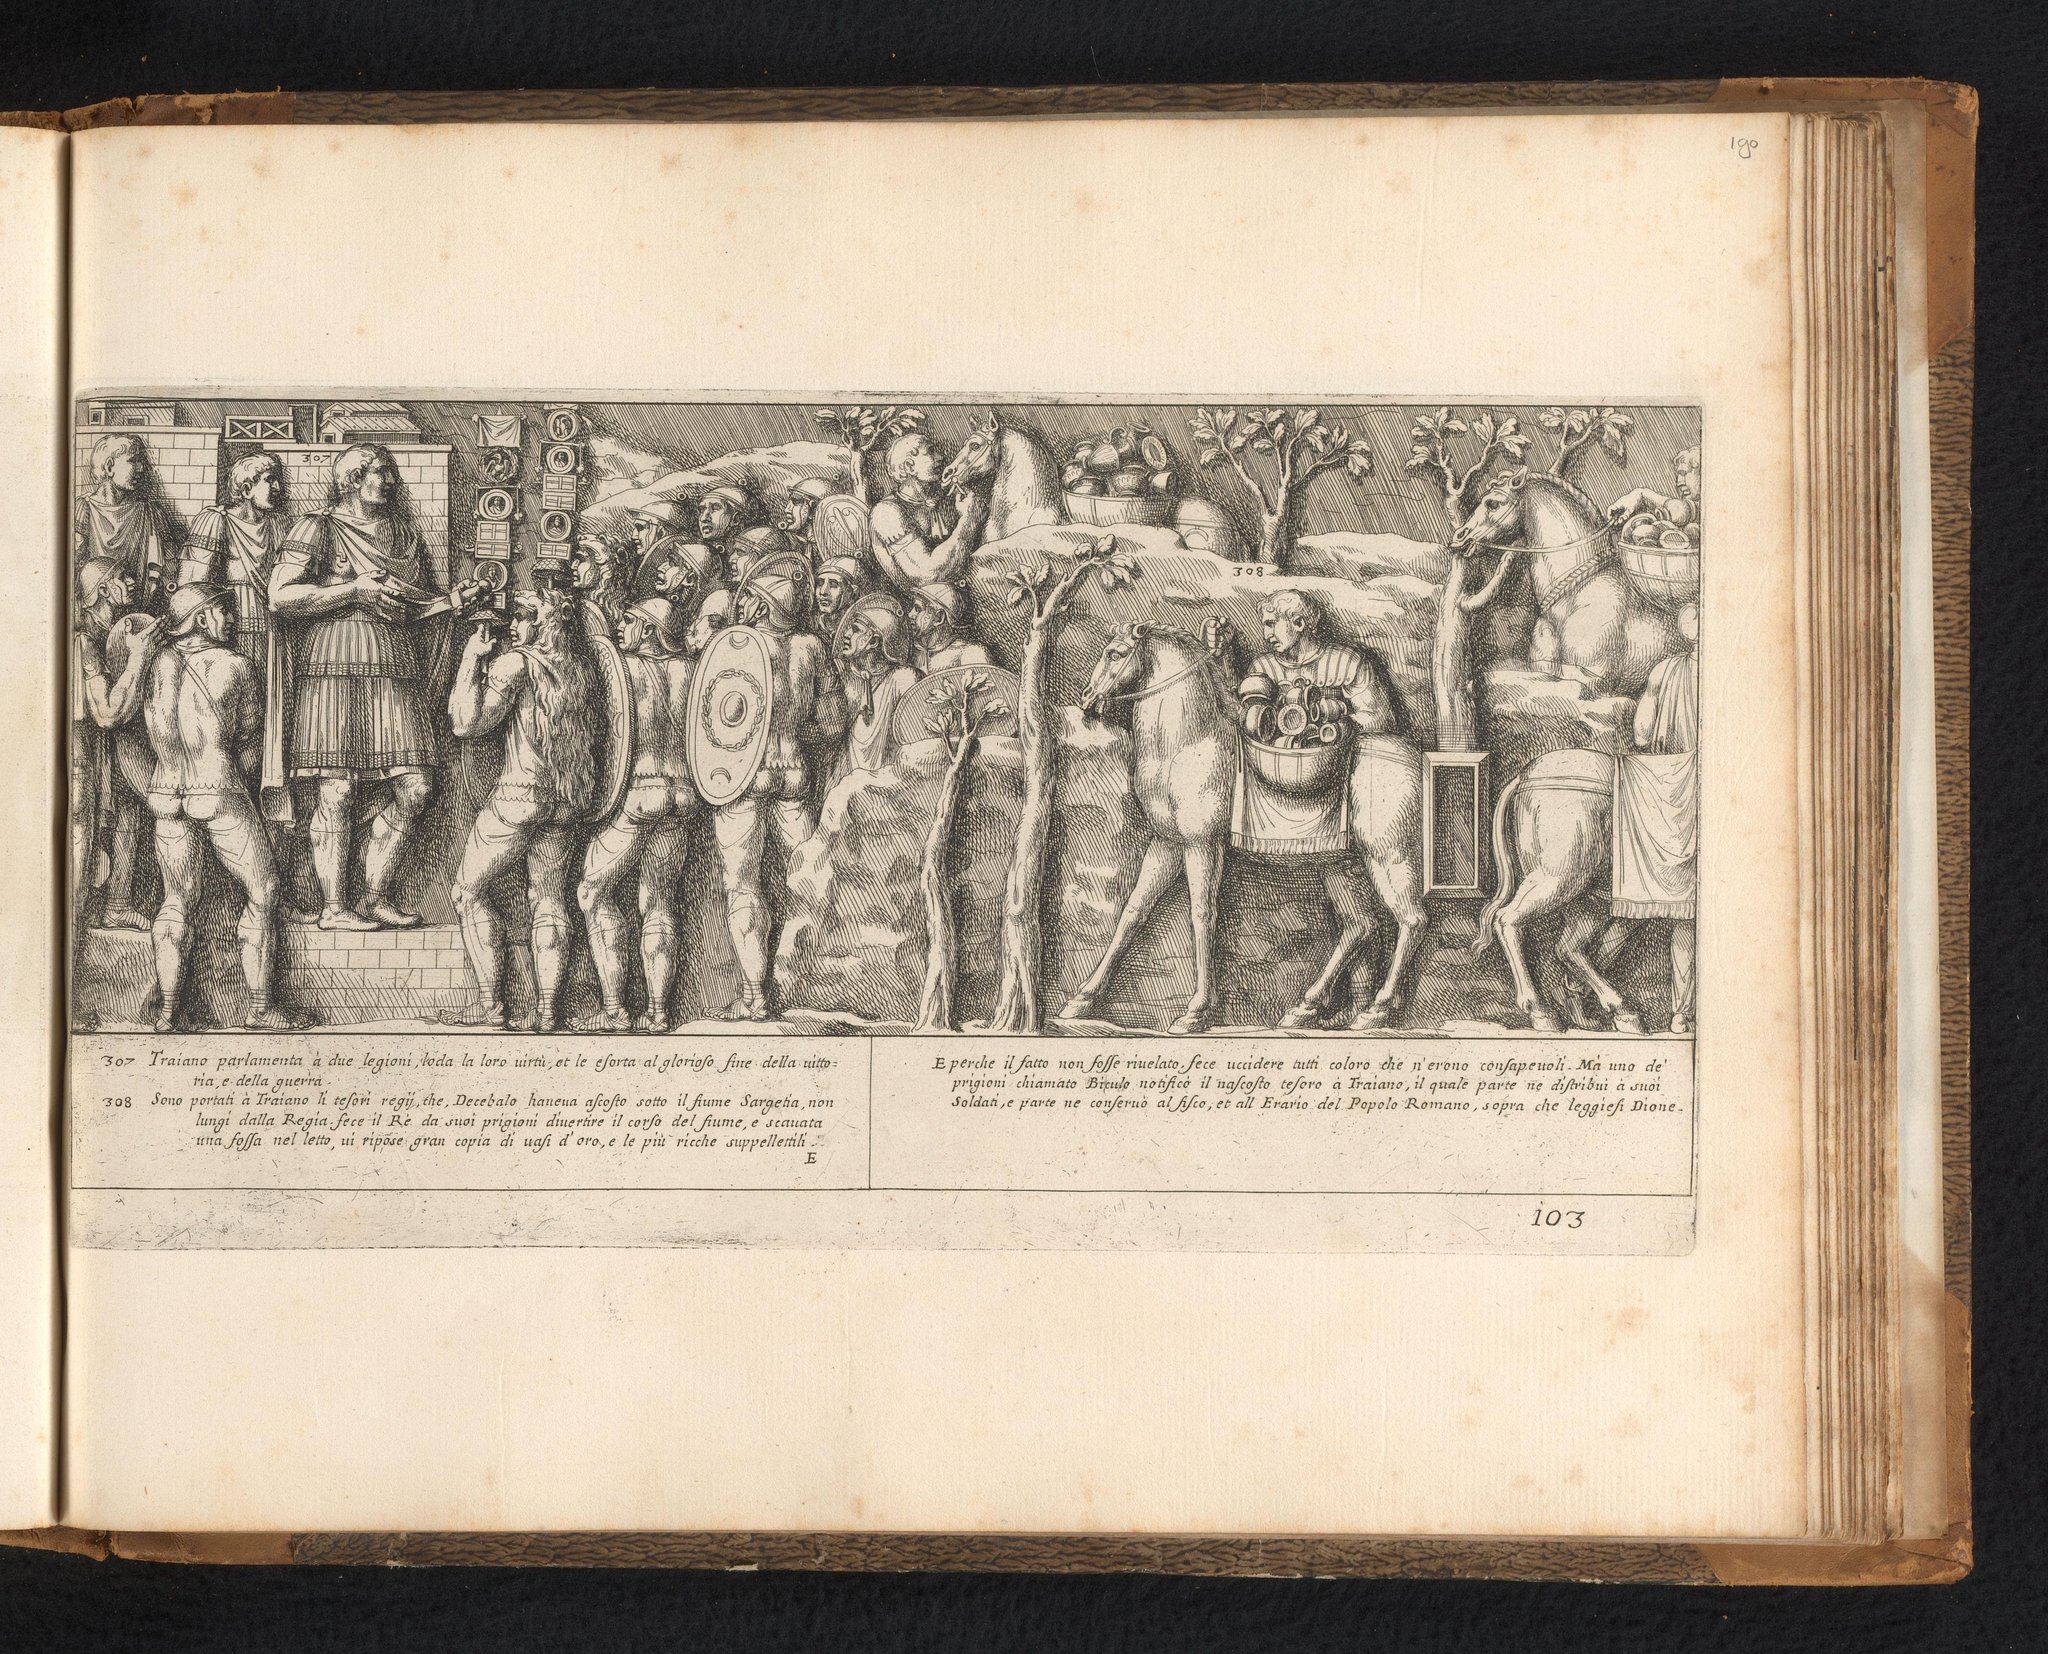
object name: print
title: Detail van het fries op de Zuil van Trajanus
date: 1637-1691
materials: paper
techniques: etching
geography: rome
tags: triumphal column with helical friezes, piece of sculpture, reproduction of a piece of sculpture, the soldier; the soldier's life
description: Detail van het spiraalvormige gebeeldhouwde fries op de Zuil van Trajanus. Het fries toont de oorlogen tussen de Romeinen en de Daciërs. Verklarende nummers in de ondermarge. Prent maakt deel uit van een album.